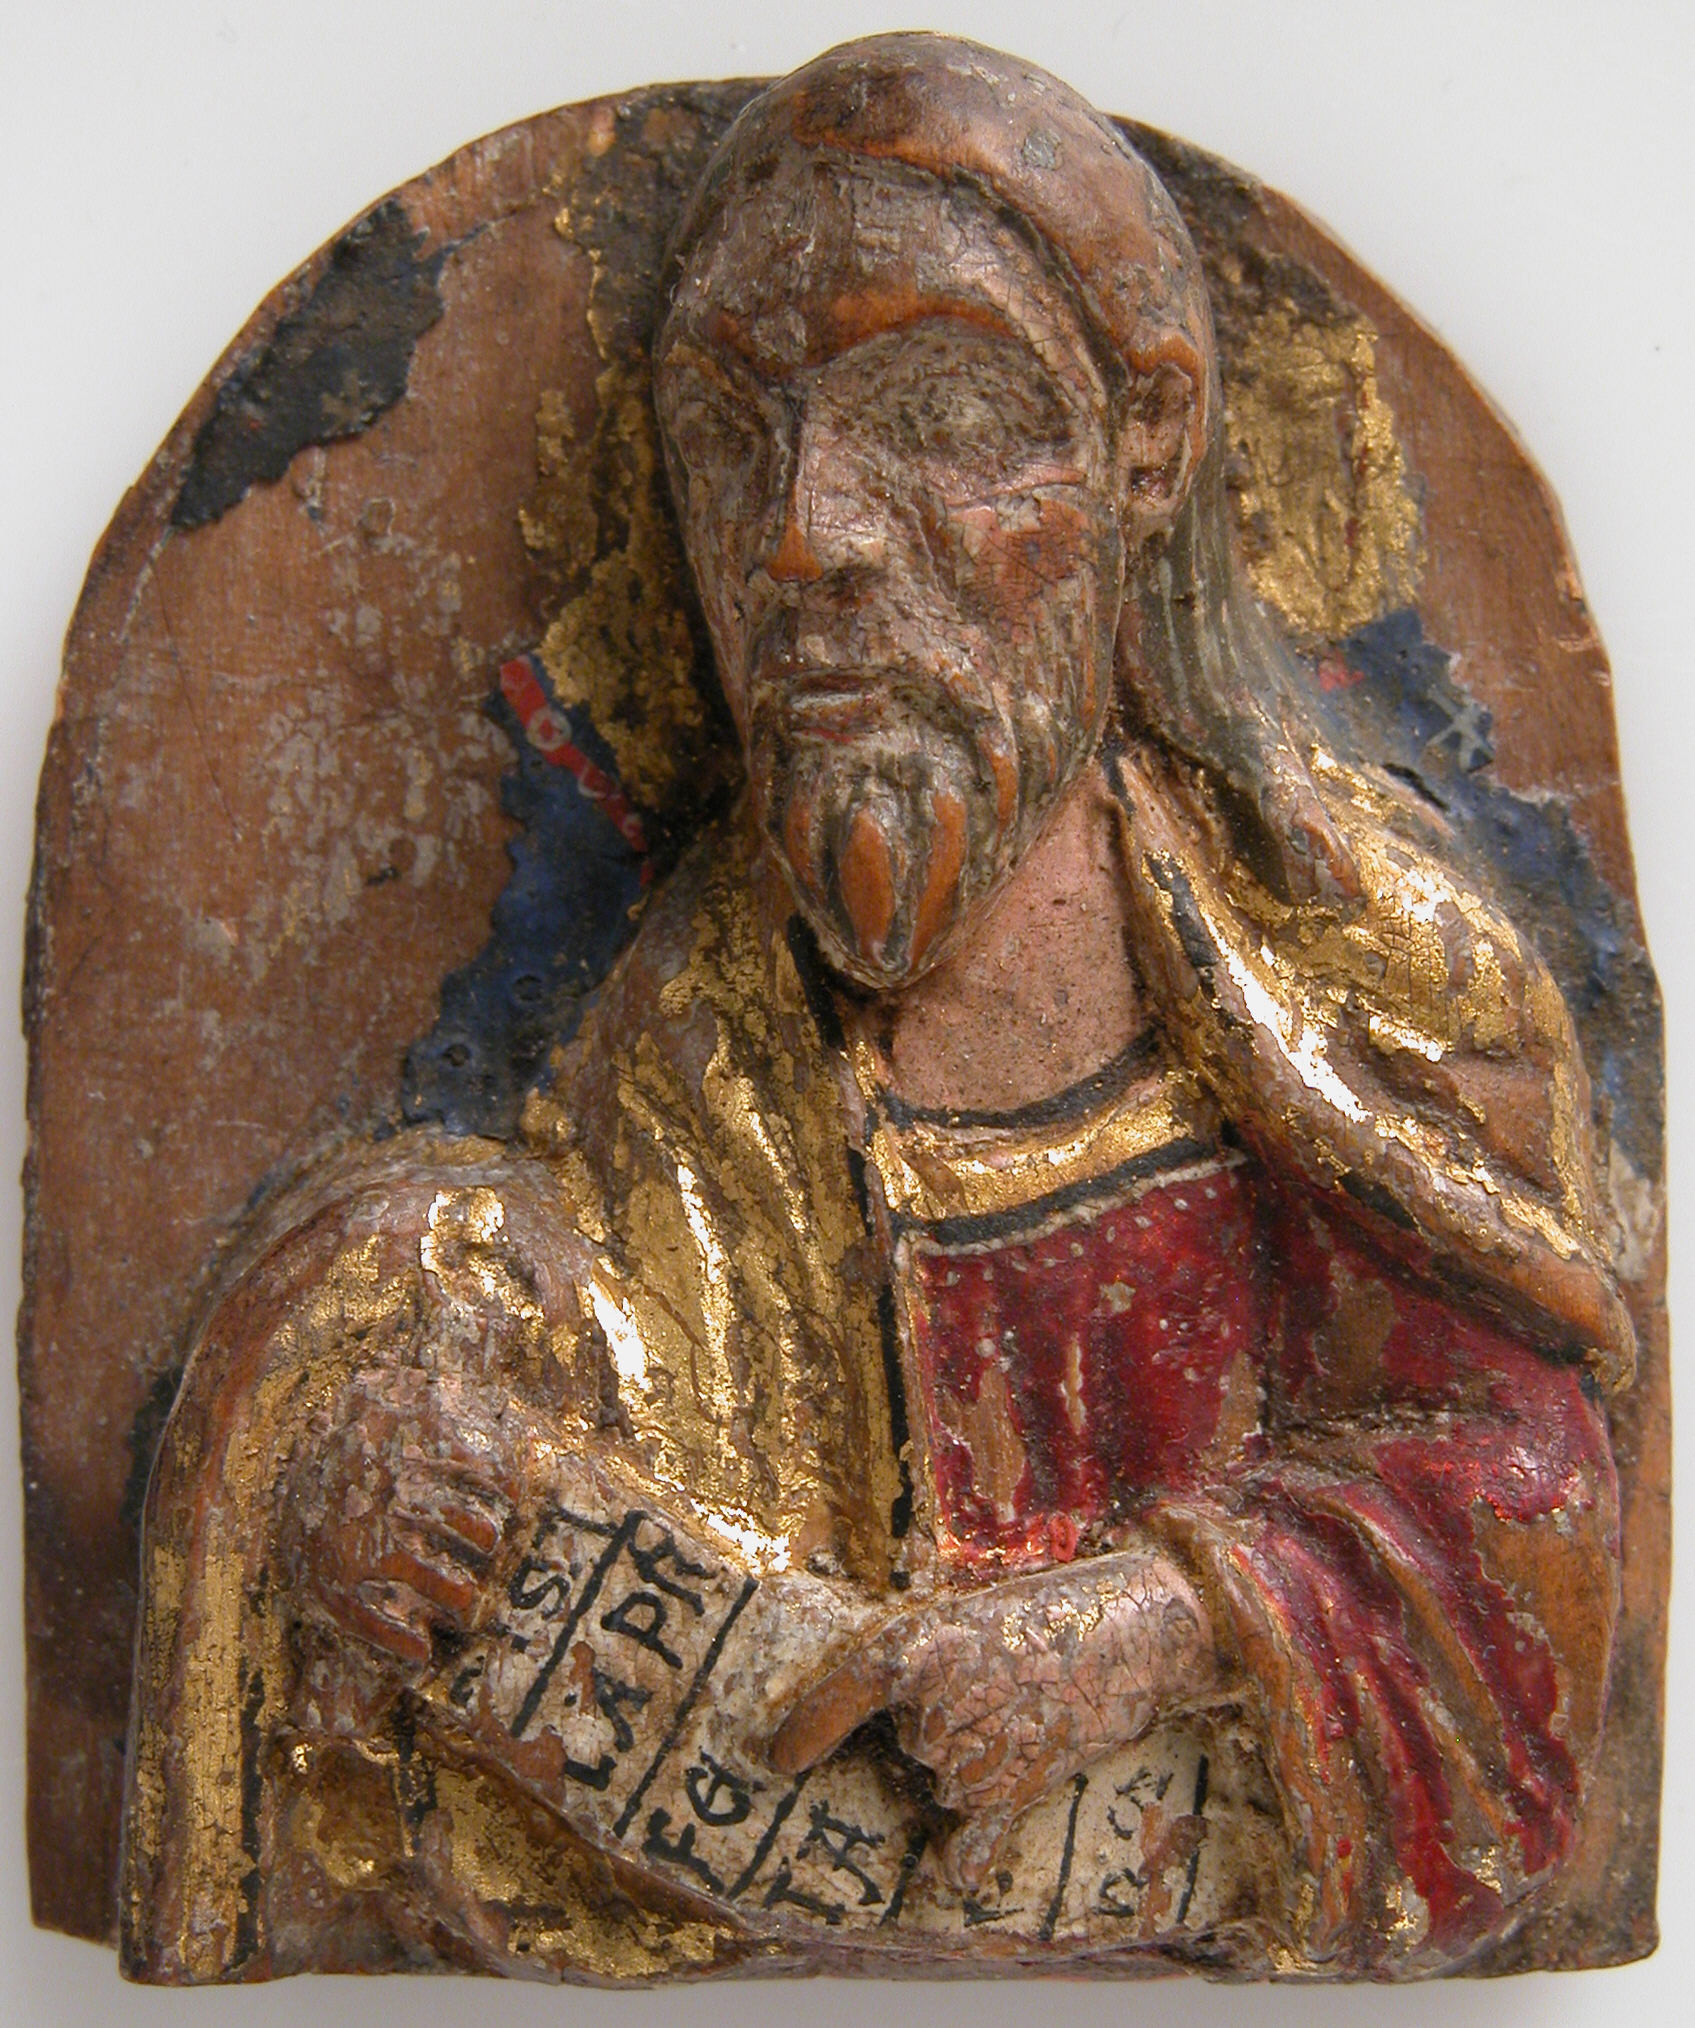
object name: relief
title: Miniature Relief of Hebrew Prophet Isaiah with Scroll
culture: german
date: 1200-1225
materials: wood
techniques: gilding, polychromy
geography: germany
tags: scrolls